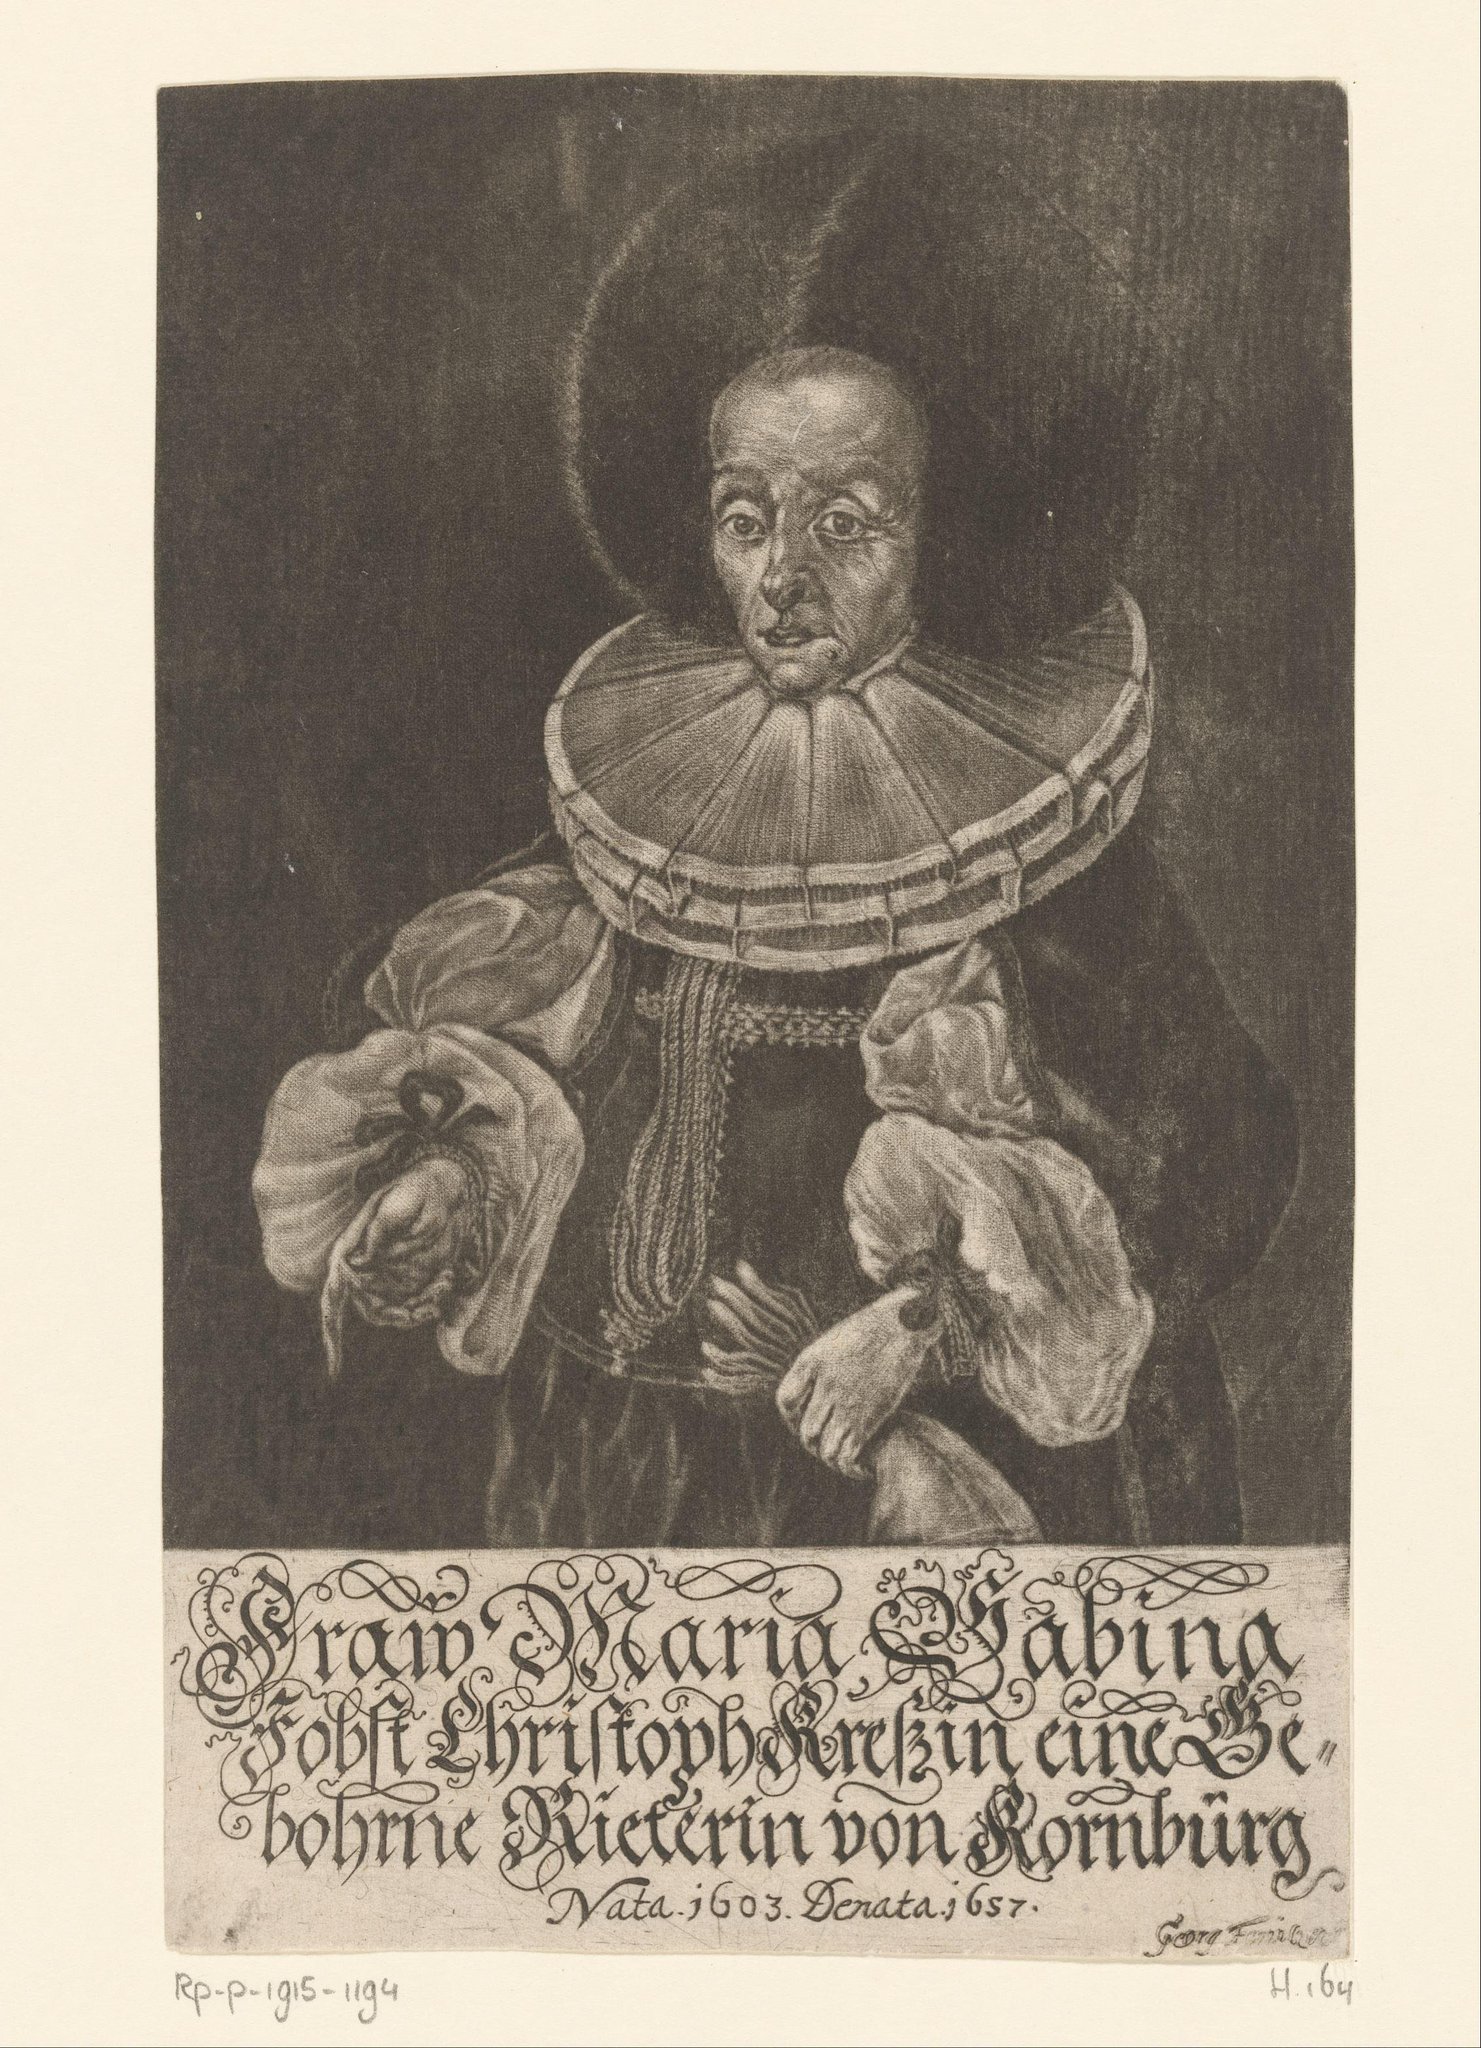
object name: print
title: Portret van Maria Sabina Kress von Kressenstein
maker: georg fennitzer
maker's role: print maker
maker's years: 1646-1722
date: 1657-1722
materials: paper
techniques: mezzotint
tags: historical persons - bb - woman, gloves, mittens, etc., head-gear: hat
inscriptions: collector's mark: Lugt 2228